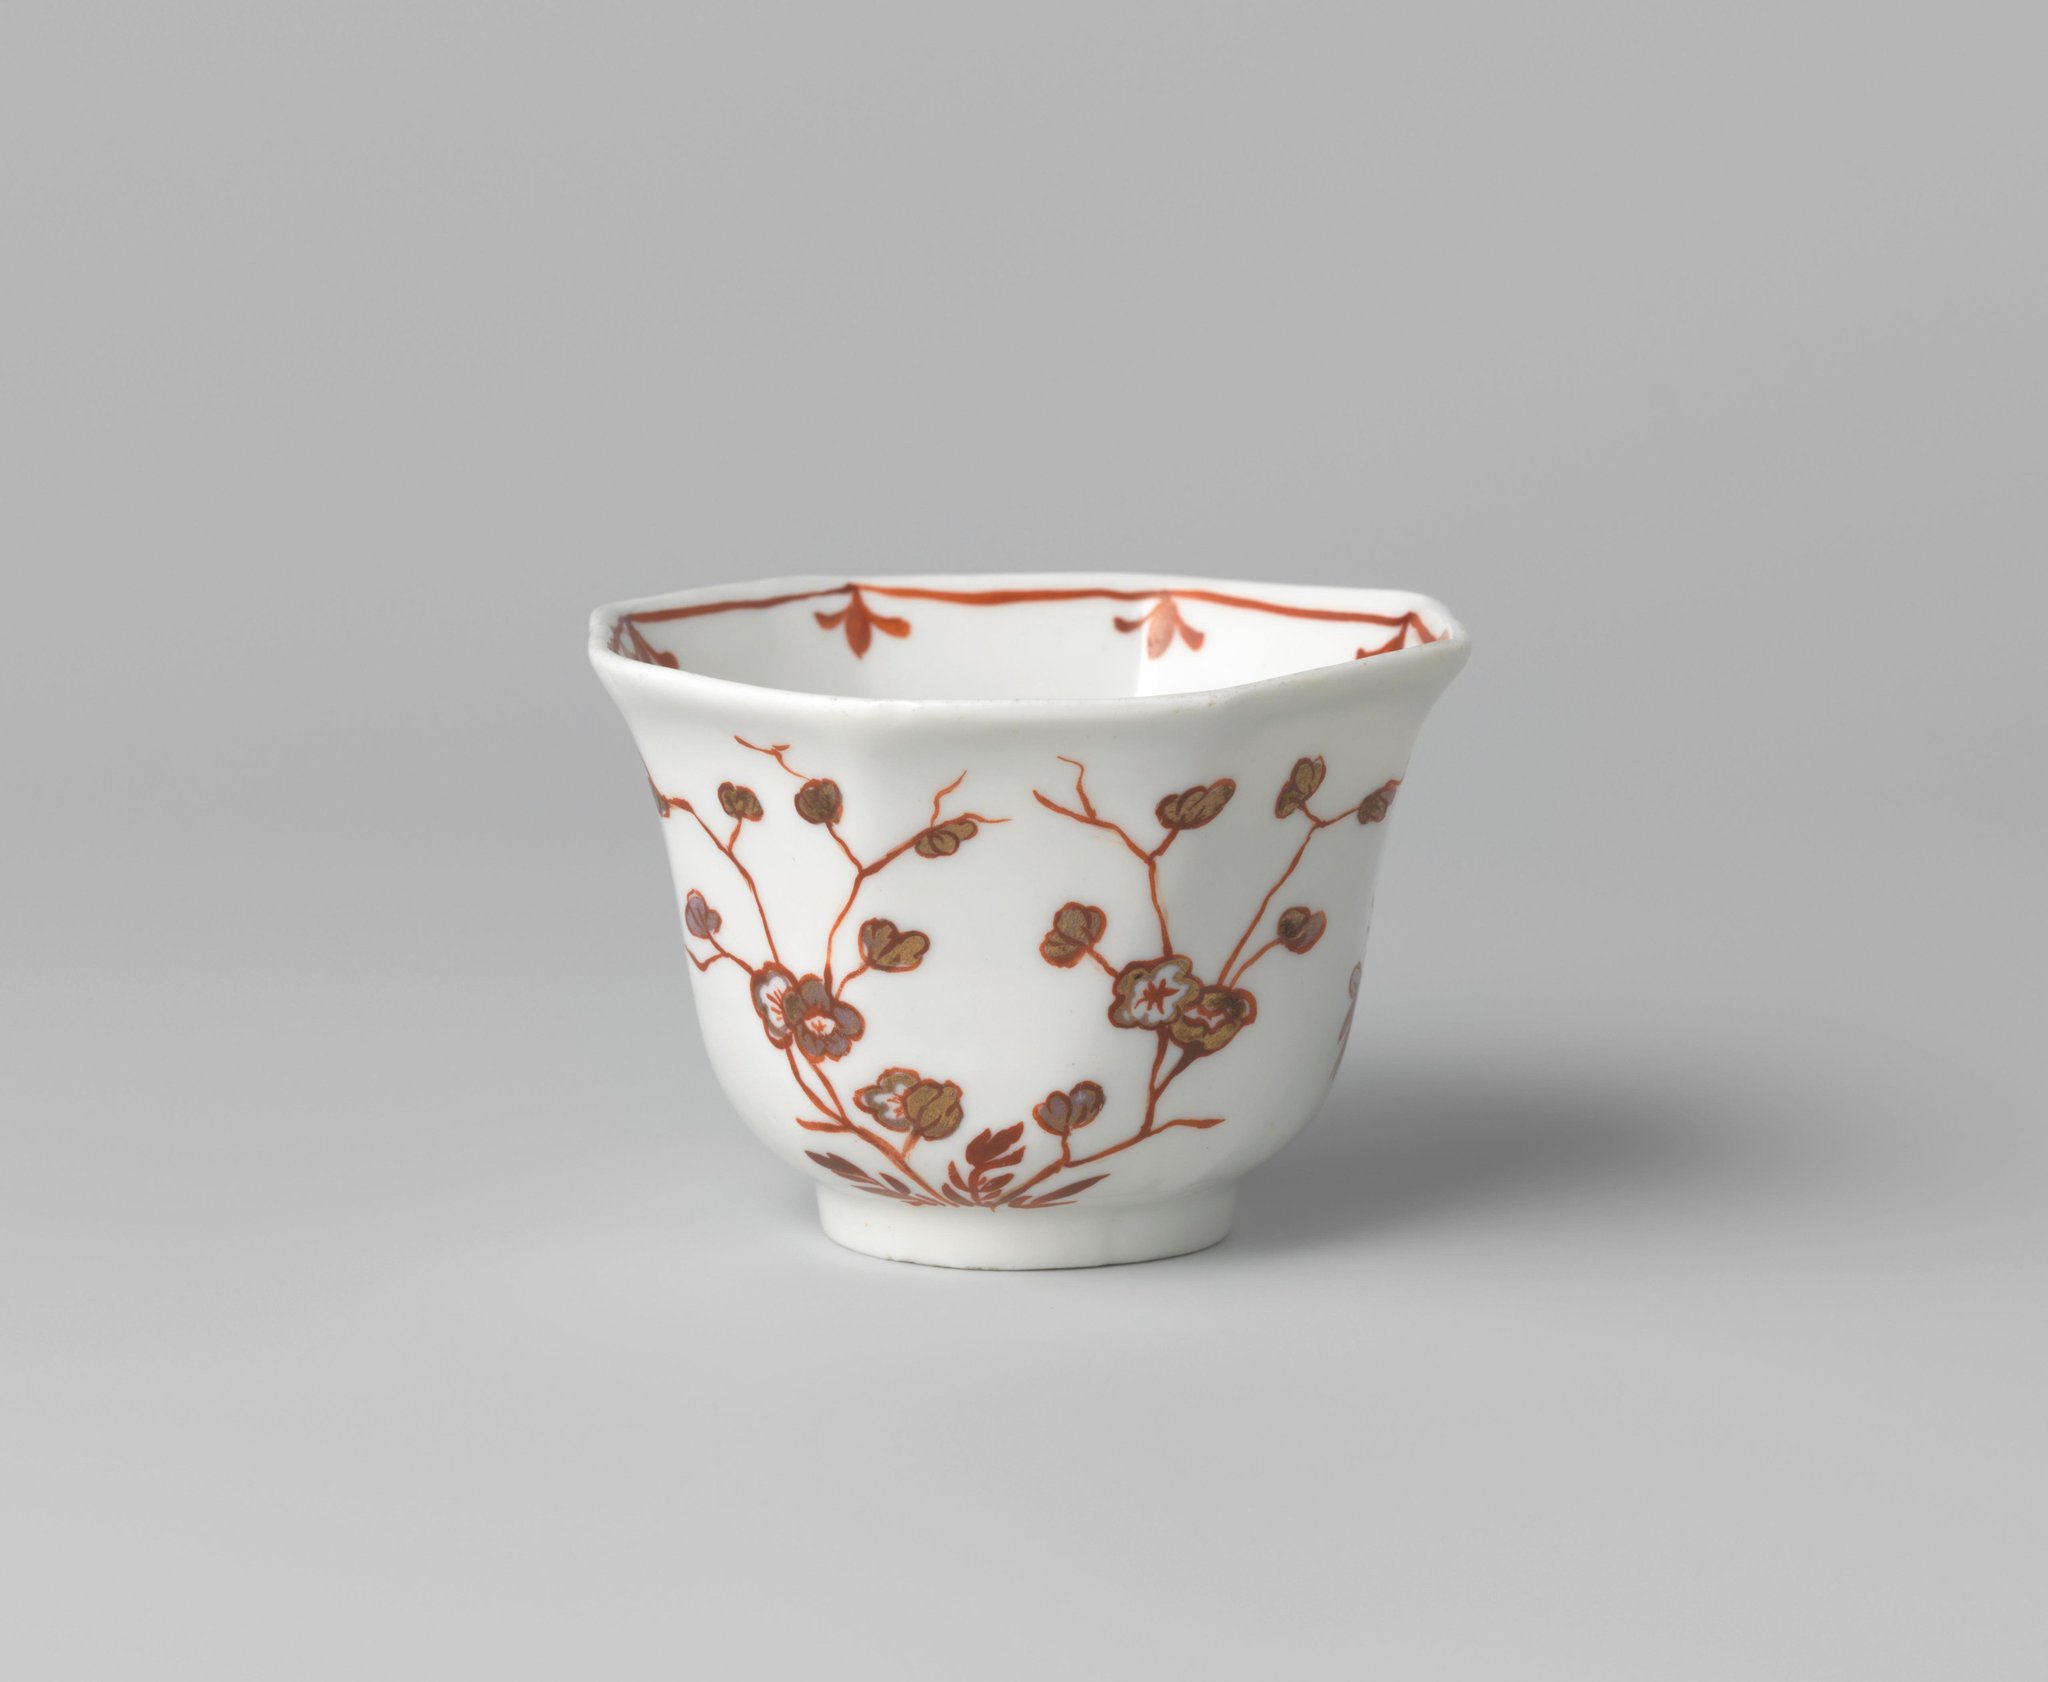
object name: cup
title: Cup with flowering plants an insects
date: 1720-1727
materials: glaze, gold, paint, porcelain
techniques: firing, forming, gilding, vitrification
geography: venice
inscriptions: mark: ‘VEN:A/ W/ A’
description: Achthoekige kop van porselein, beschilderd op het glazuur in rood en goud. De buitenwand met twee bloeiende planten (prunus), waartussen een insect. Een band met bladmotieven op de binnenrand. Op de bodem een ster. Gemerkt op de onderzijde met VEN:A, M en A.